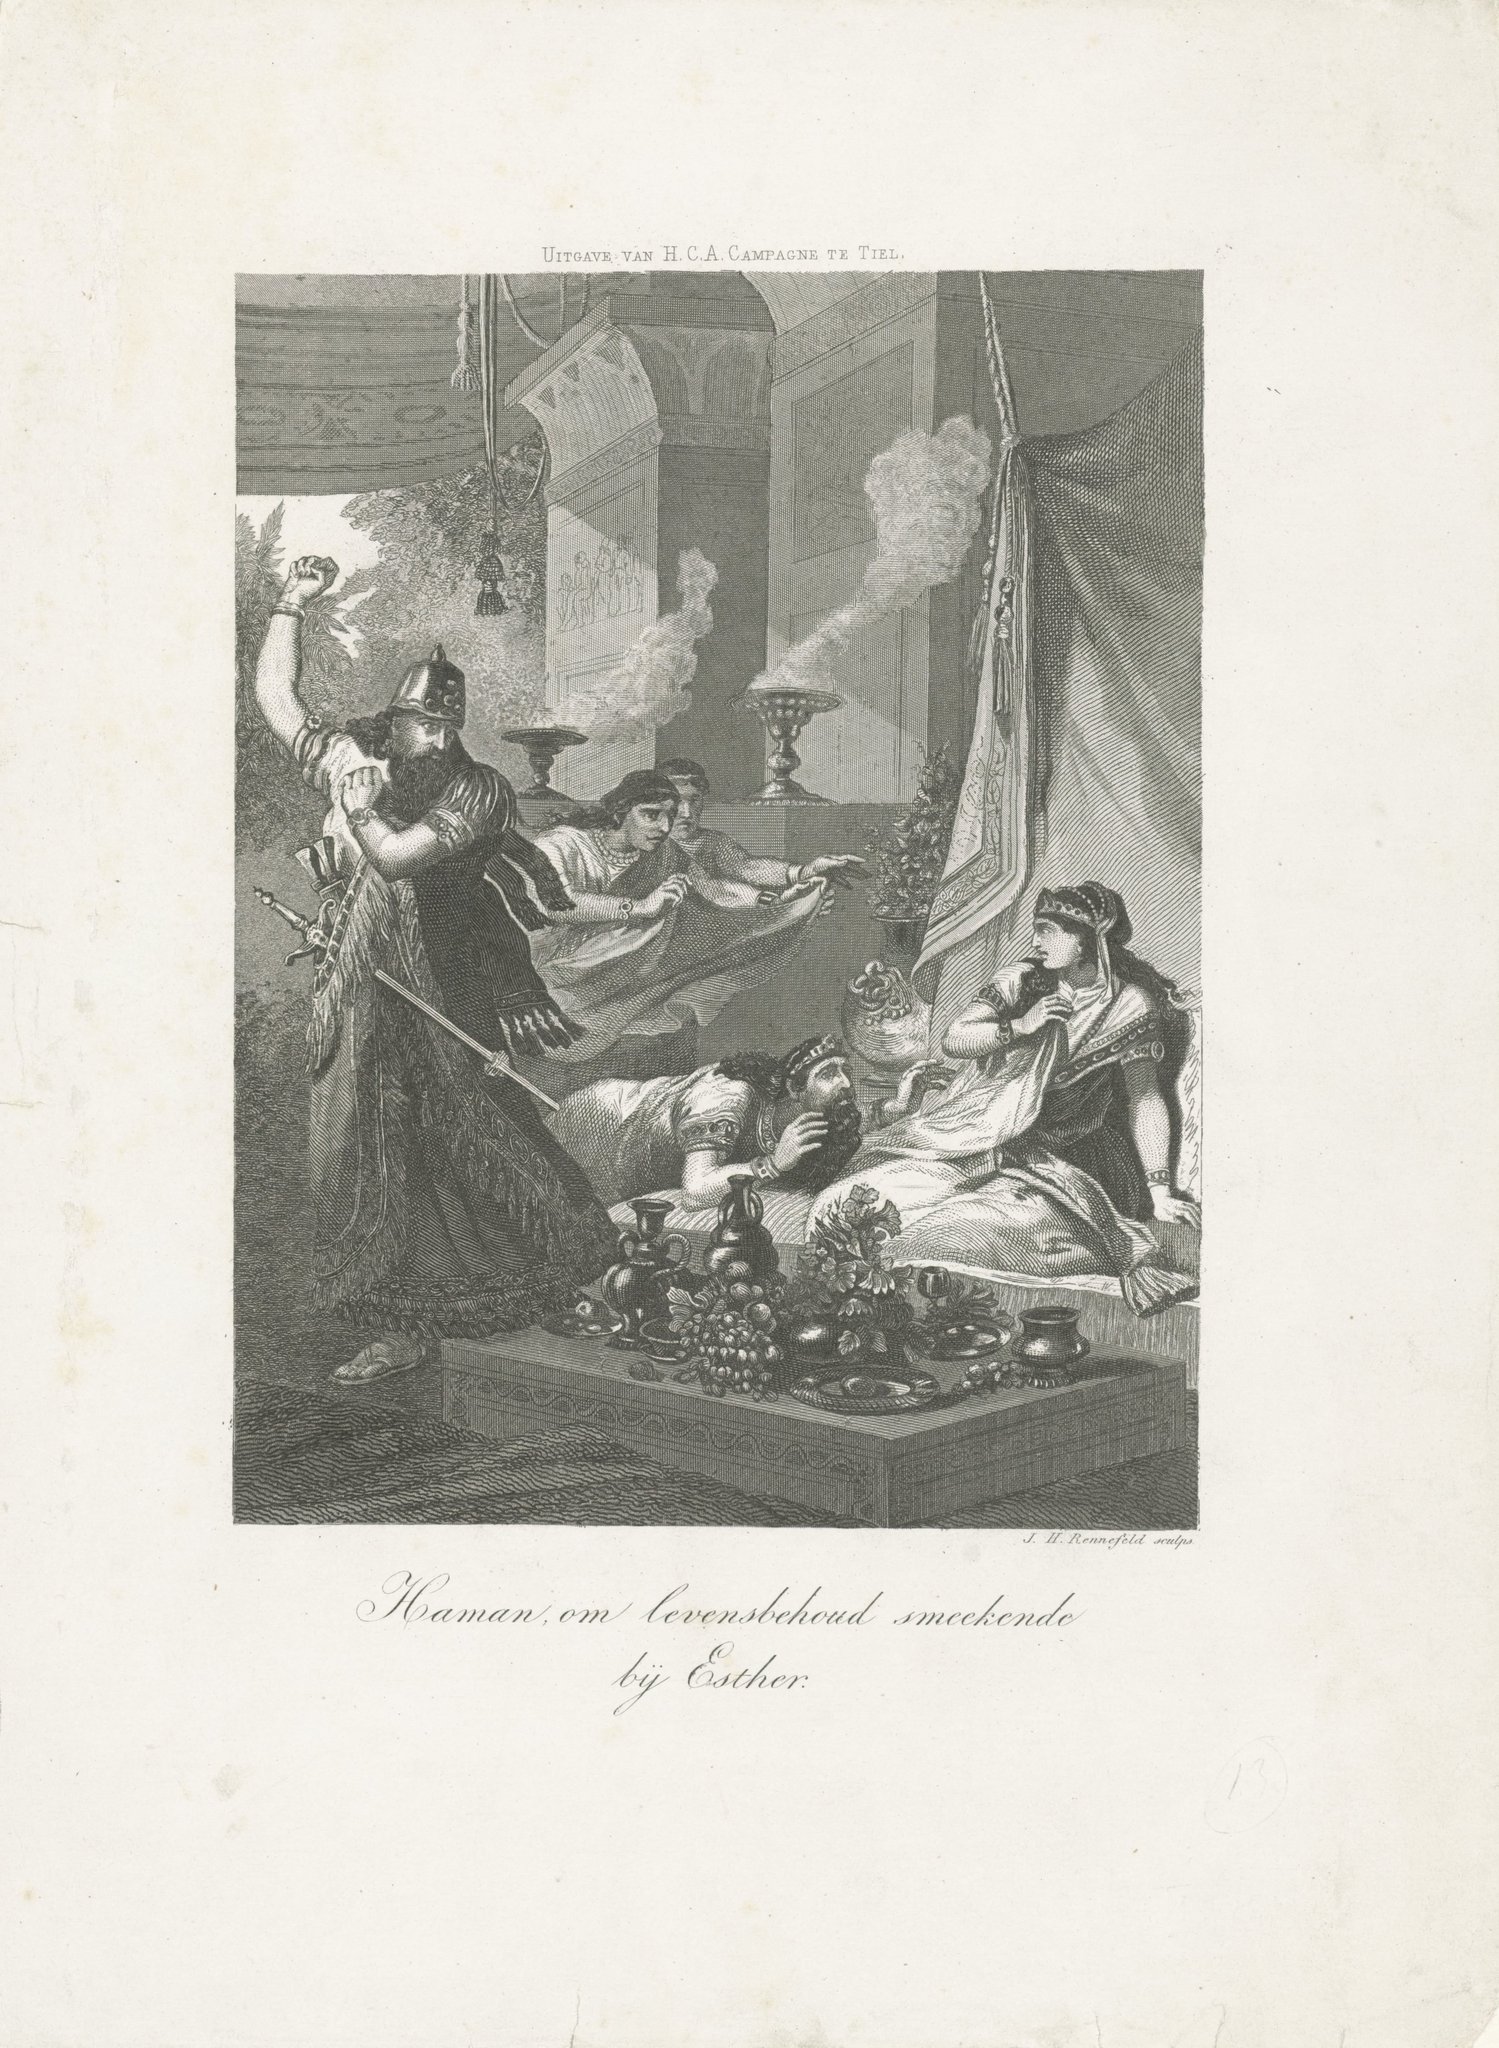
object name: print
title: Haman smeekt Ester om zijn leven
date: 1845-1877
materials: paper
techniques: roulette, engraving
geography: amsterdam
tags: haman begs esther for his life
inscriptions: collector's mark: Lugt 2228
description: Haman knielt voor koningin Ester en smeekt haar om zijn leven. De Perzische koning Ahasveros maakt een afwijzend gebaar.